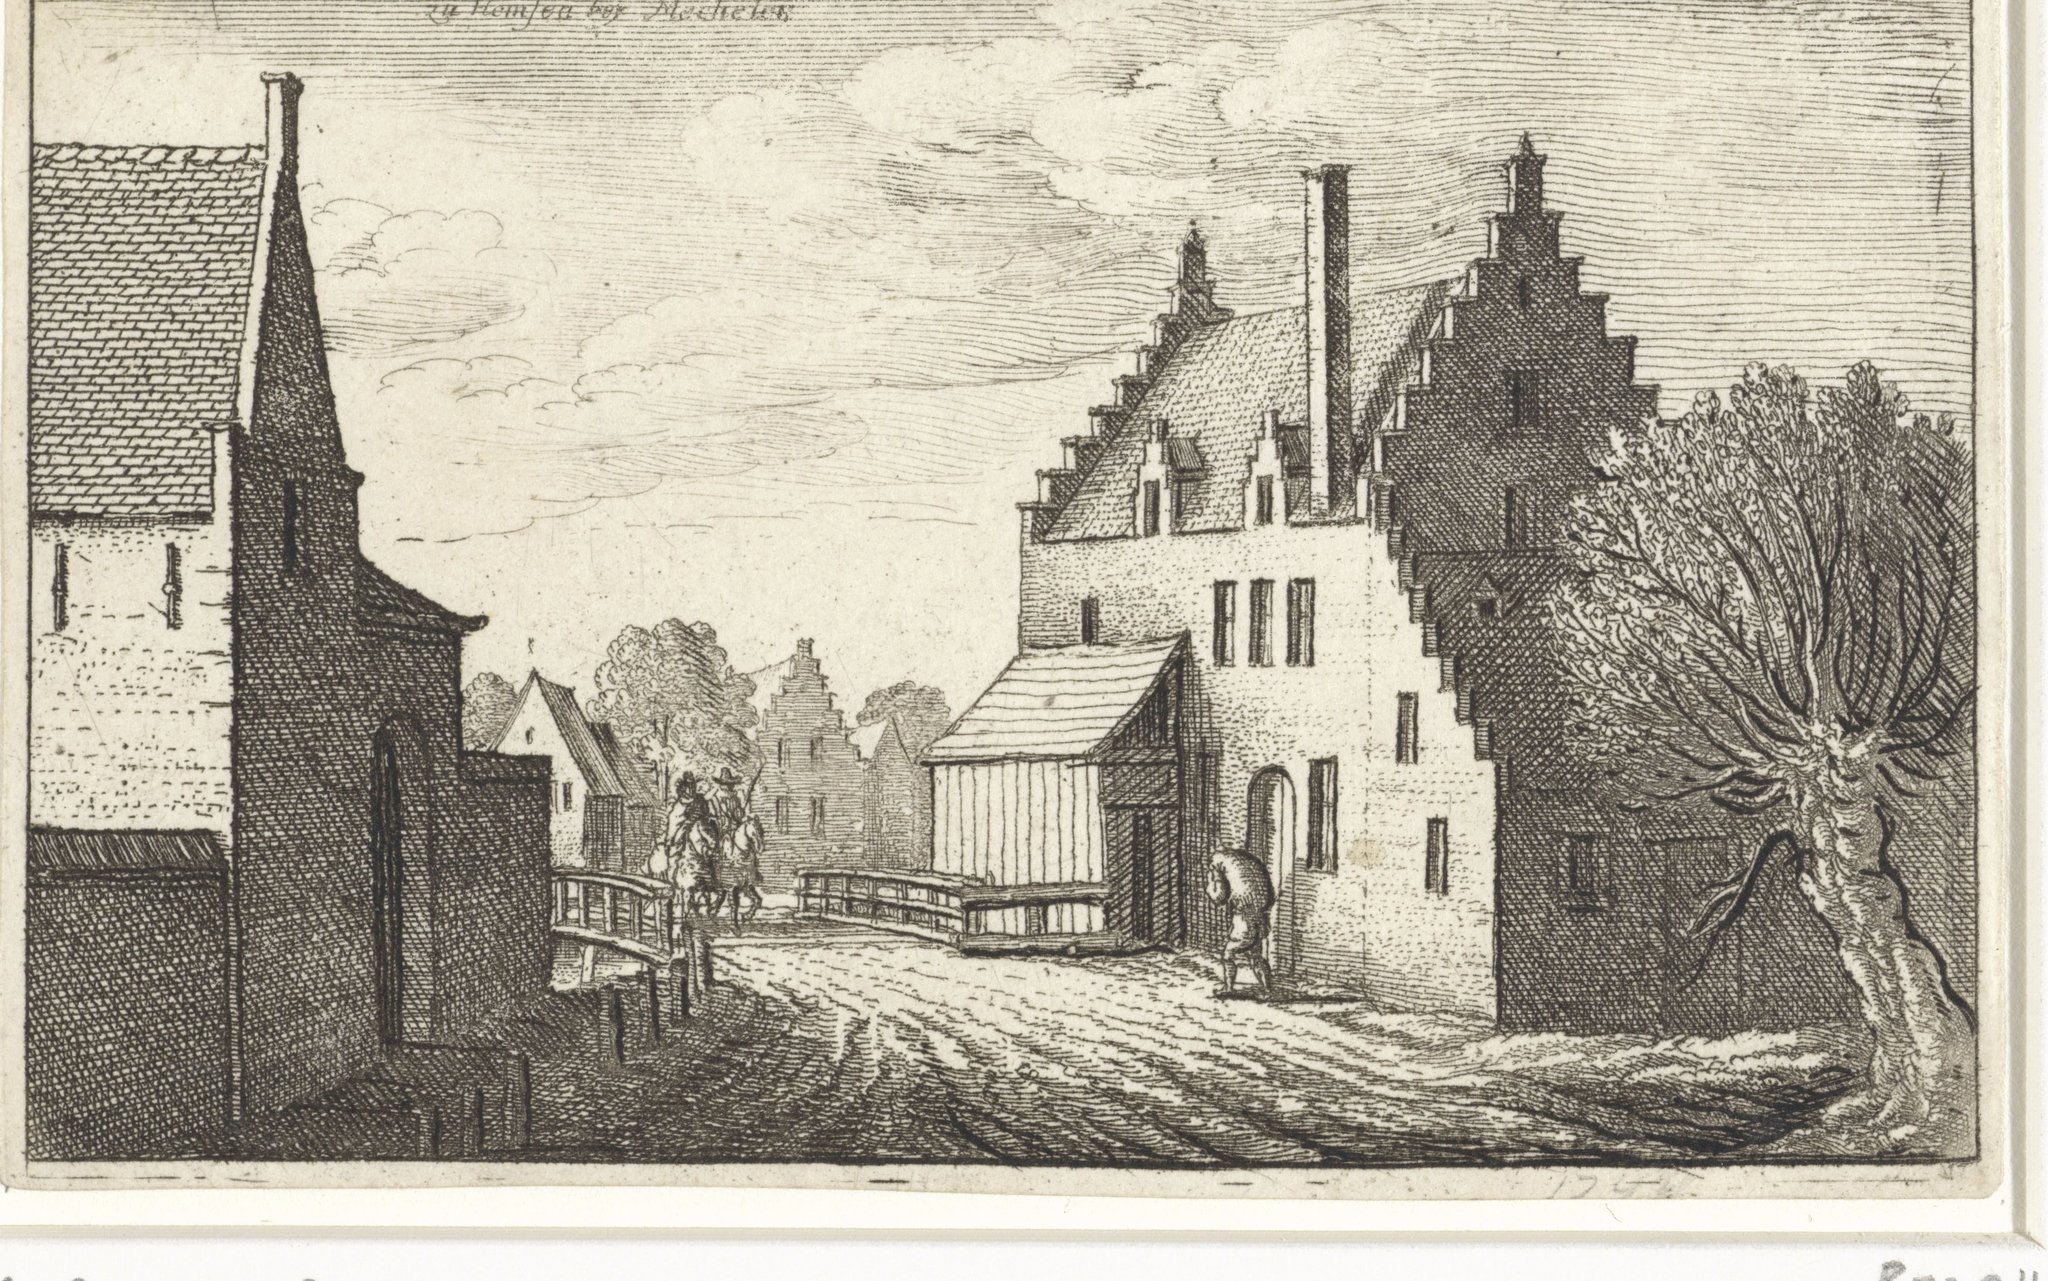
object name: print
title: Gezichten op Europese steden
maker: wenceslaus hollar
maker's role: draughtsman, print maker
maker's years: 1607-1677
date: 1664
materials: paper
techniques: etching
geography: london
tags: village street, mechelen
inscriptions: collector's mark: Lugt 2228, collector's mark, collector's mark: Lugt 2760